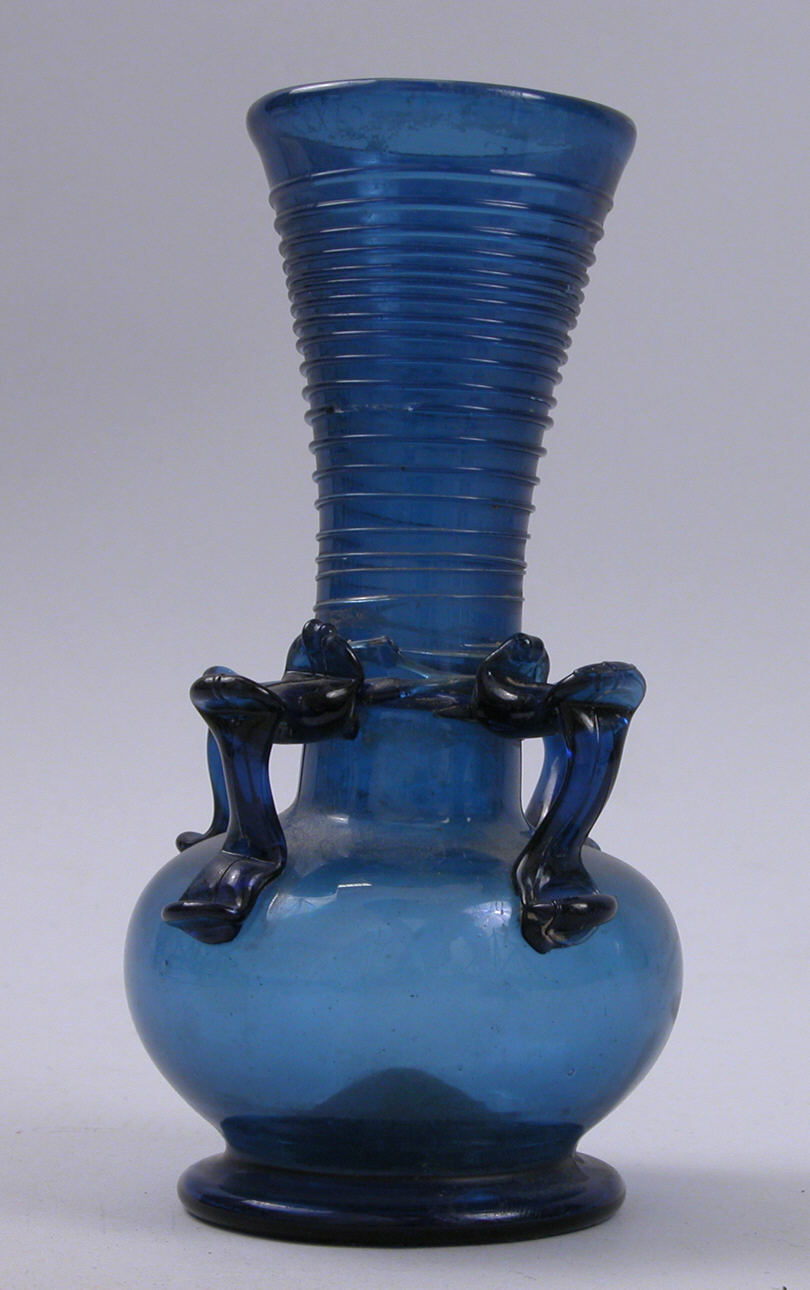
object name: vase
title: Bottle with Four Handles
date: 1801-1900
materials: glass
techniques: glassblowing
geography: iran